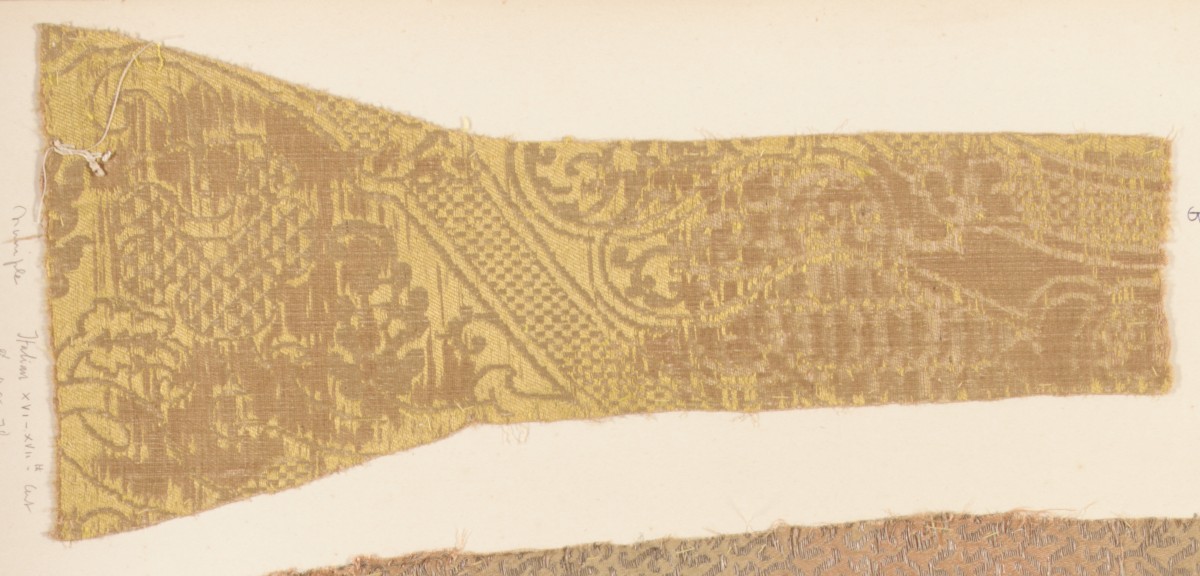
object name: fragment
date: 1567-1700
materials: silk